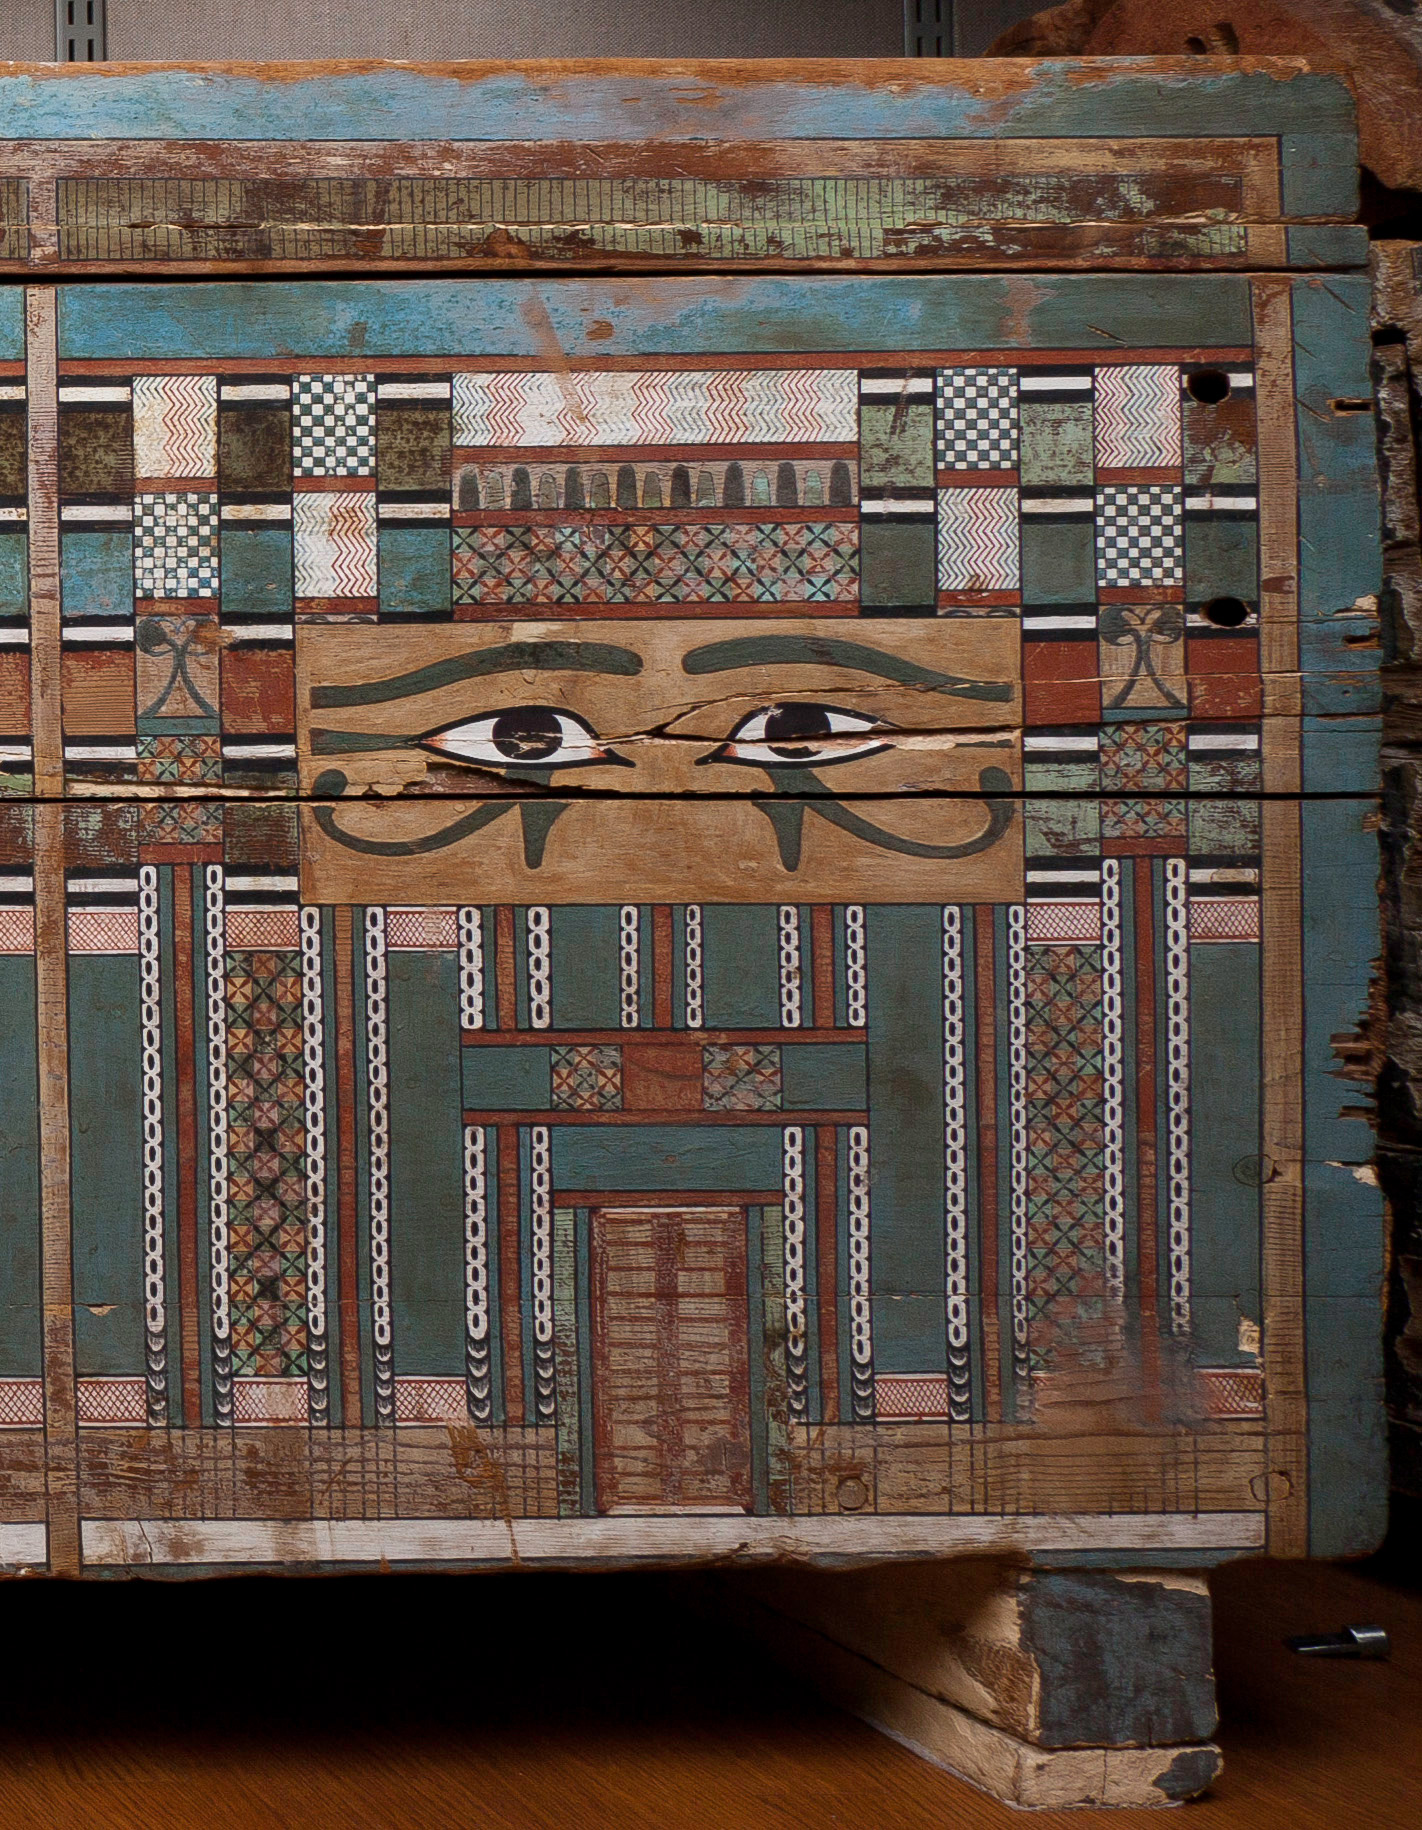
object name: coffin, ameny, rectangular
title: Coffin of Ameny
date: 1981-1802 BCE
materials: paint, wood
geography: egypt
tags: coffins